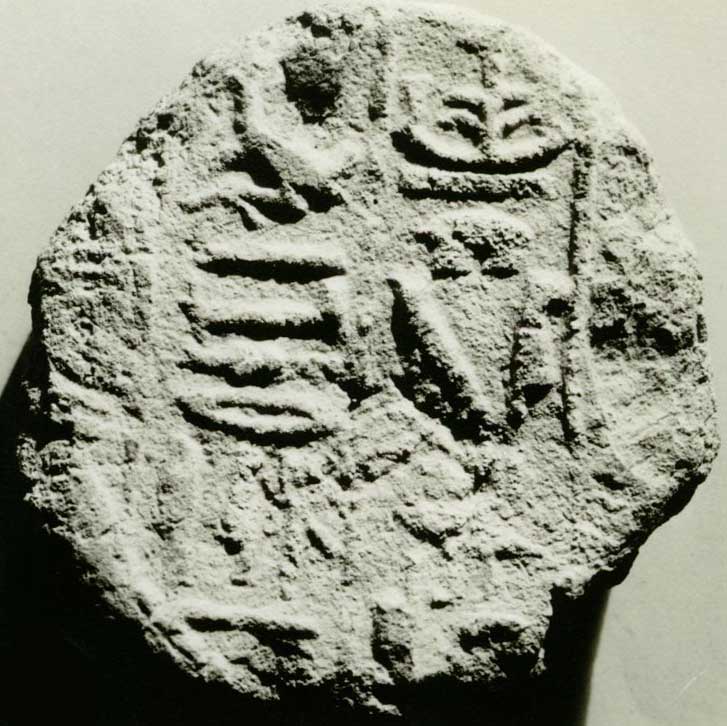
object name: cone, si iset, circular impression, standard bearer, boat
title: Funerary Cone of Si-Iset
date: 1550-1295 BCE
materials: pottery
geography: egypt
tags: hieroglyphs